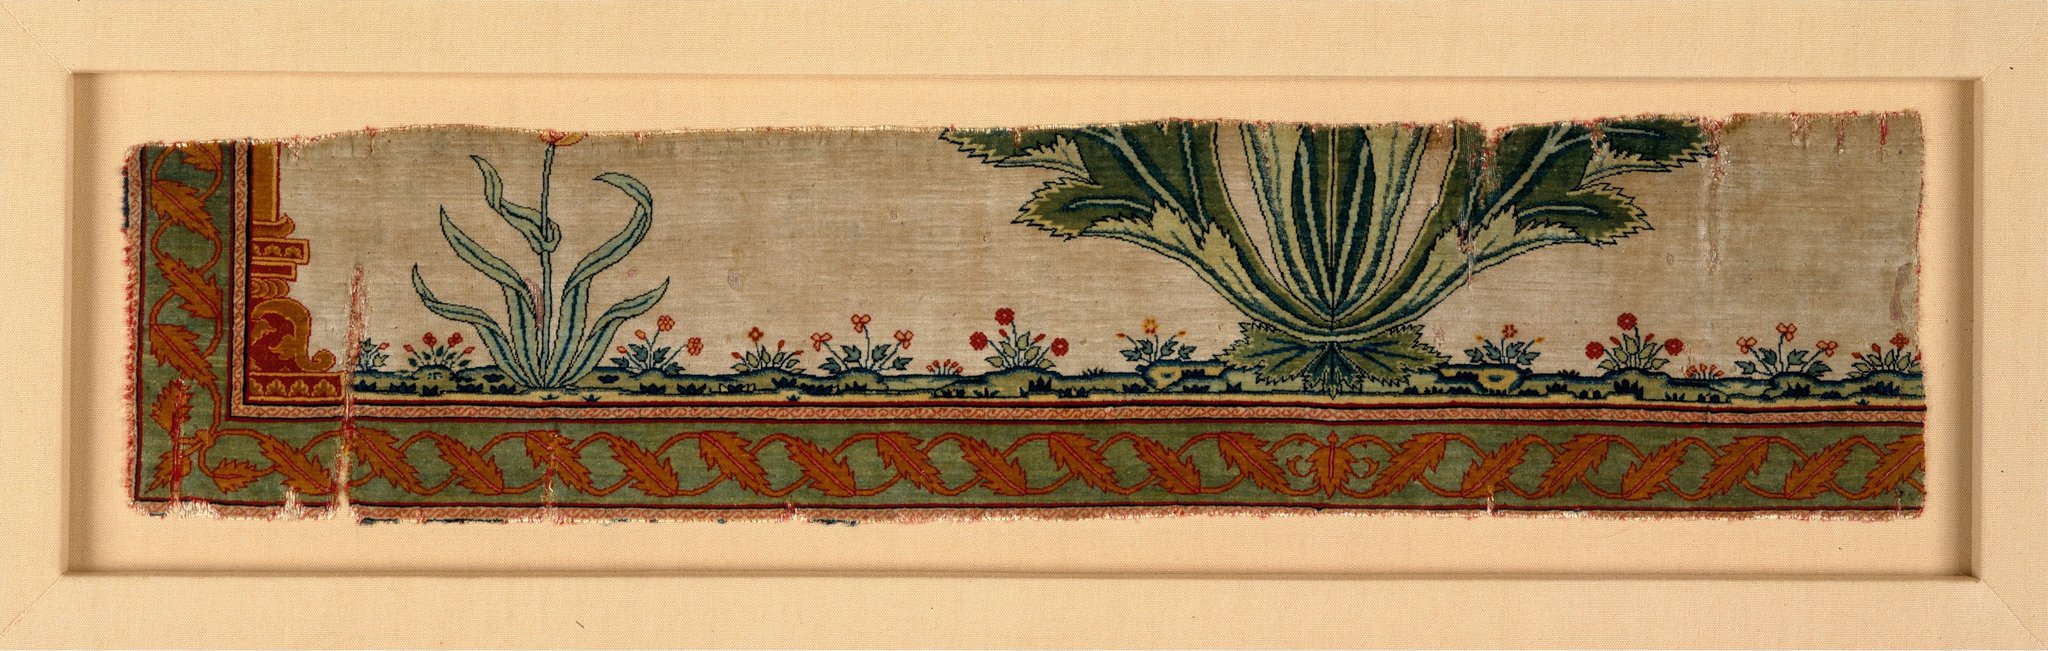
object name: carpet fragment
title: Fragment of a Carpet with Niche and Flower Design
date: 1630-1640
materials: silk, wool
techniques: asymmetrically knotted pile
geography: india